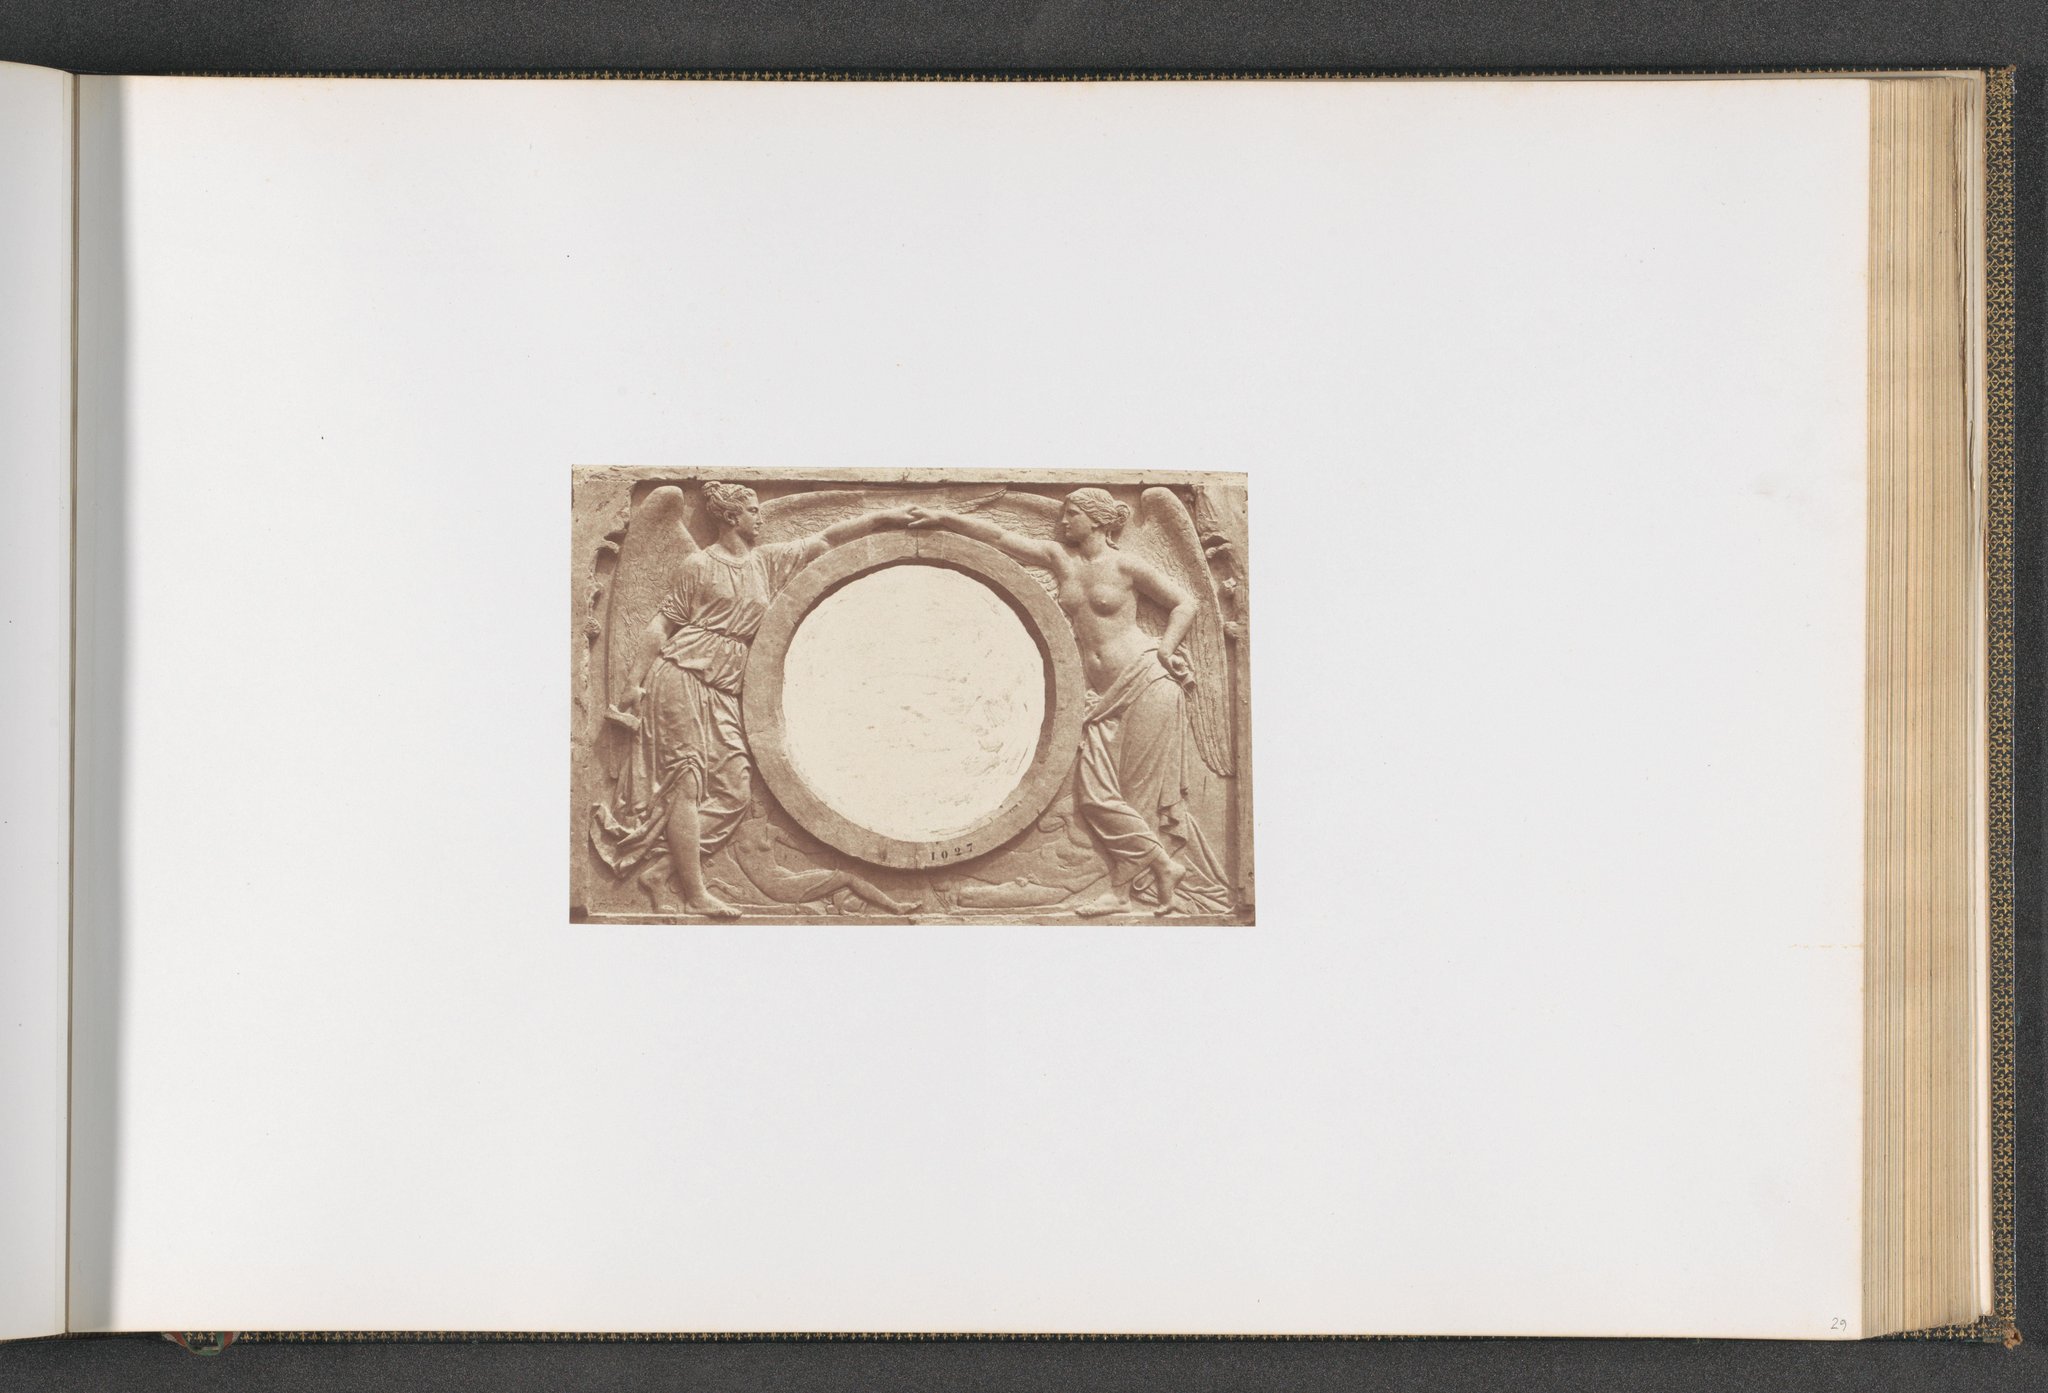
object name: album leaf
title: Gipsmodel voor beeldhouwwerk op het Palais du Louvre: "L'alliance de l'Art antique et de la Renaissance" door Jean Bonnassieux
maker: édouard denis baldus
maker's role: fotograaf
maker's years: 1813-1889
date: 1855-1857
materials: paper, photographic support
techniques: salted paper print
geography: paris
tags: piece of sculpture, reproduction of a piece of sculpture, permanent exhibition, museum, paris, tuileries palace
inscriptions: number: ‘1027’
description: Onderdeel van Réunion des Tuileries au Louvre 1852-1857, album 2.